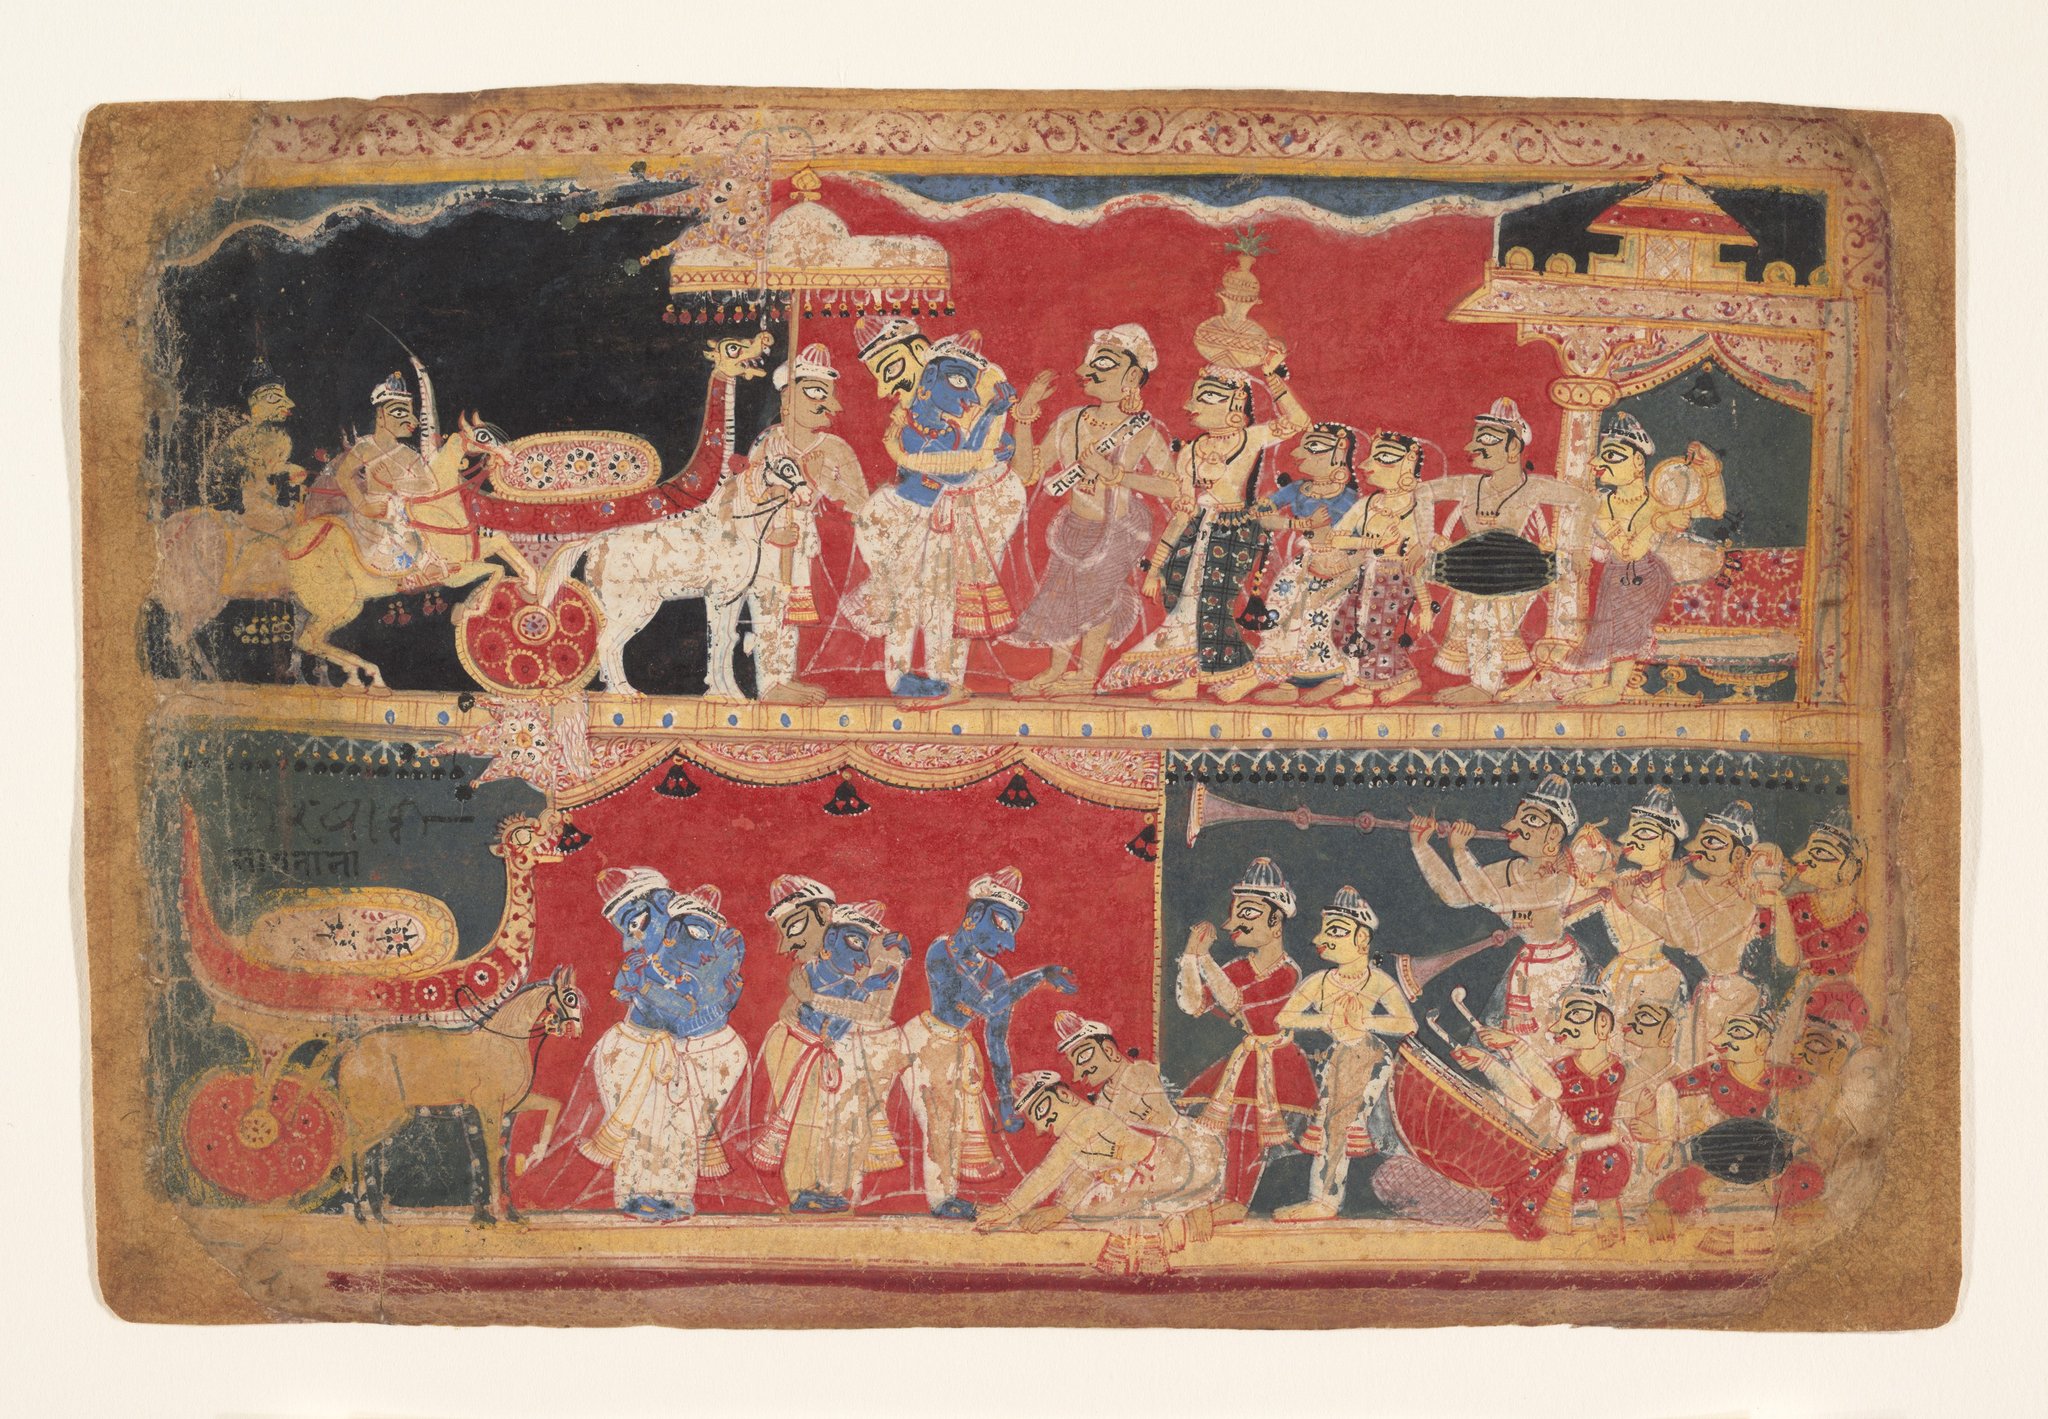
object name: folio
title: Krishna Is Welcomed into Mathura: Page from a Dispersed Bhagavata Purana Manuscript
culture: indian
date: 1520-1540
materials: ink, paper, watercolor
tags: musical instruments,men,women,horses,krishna